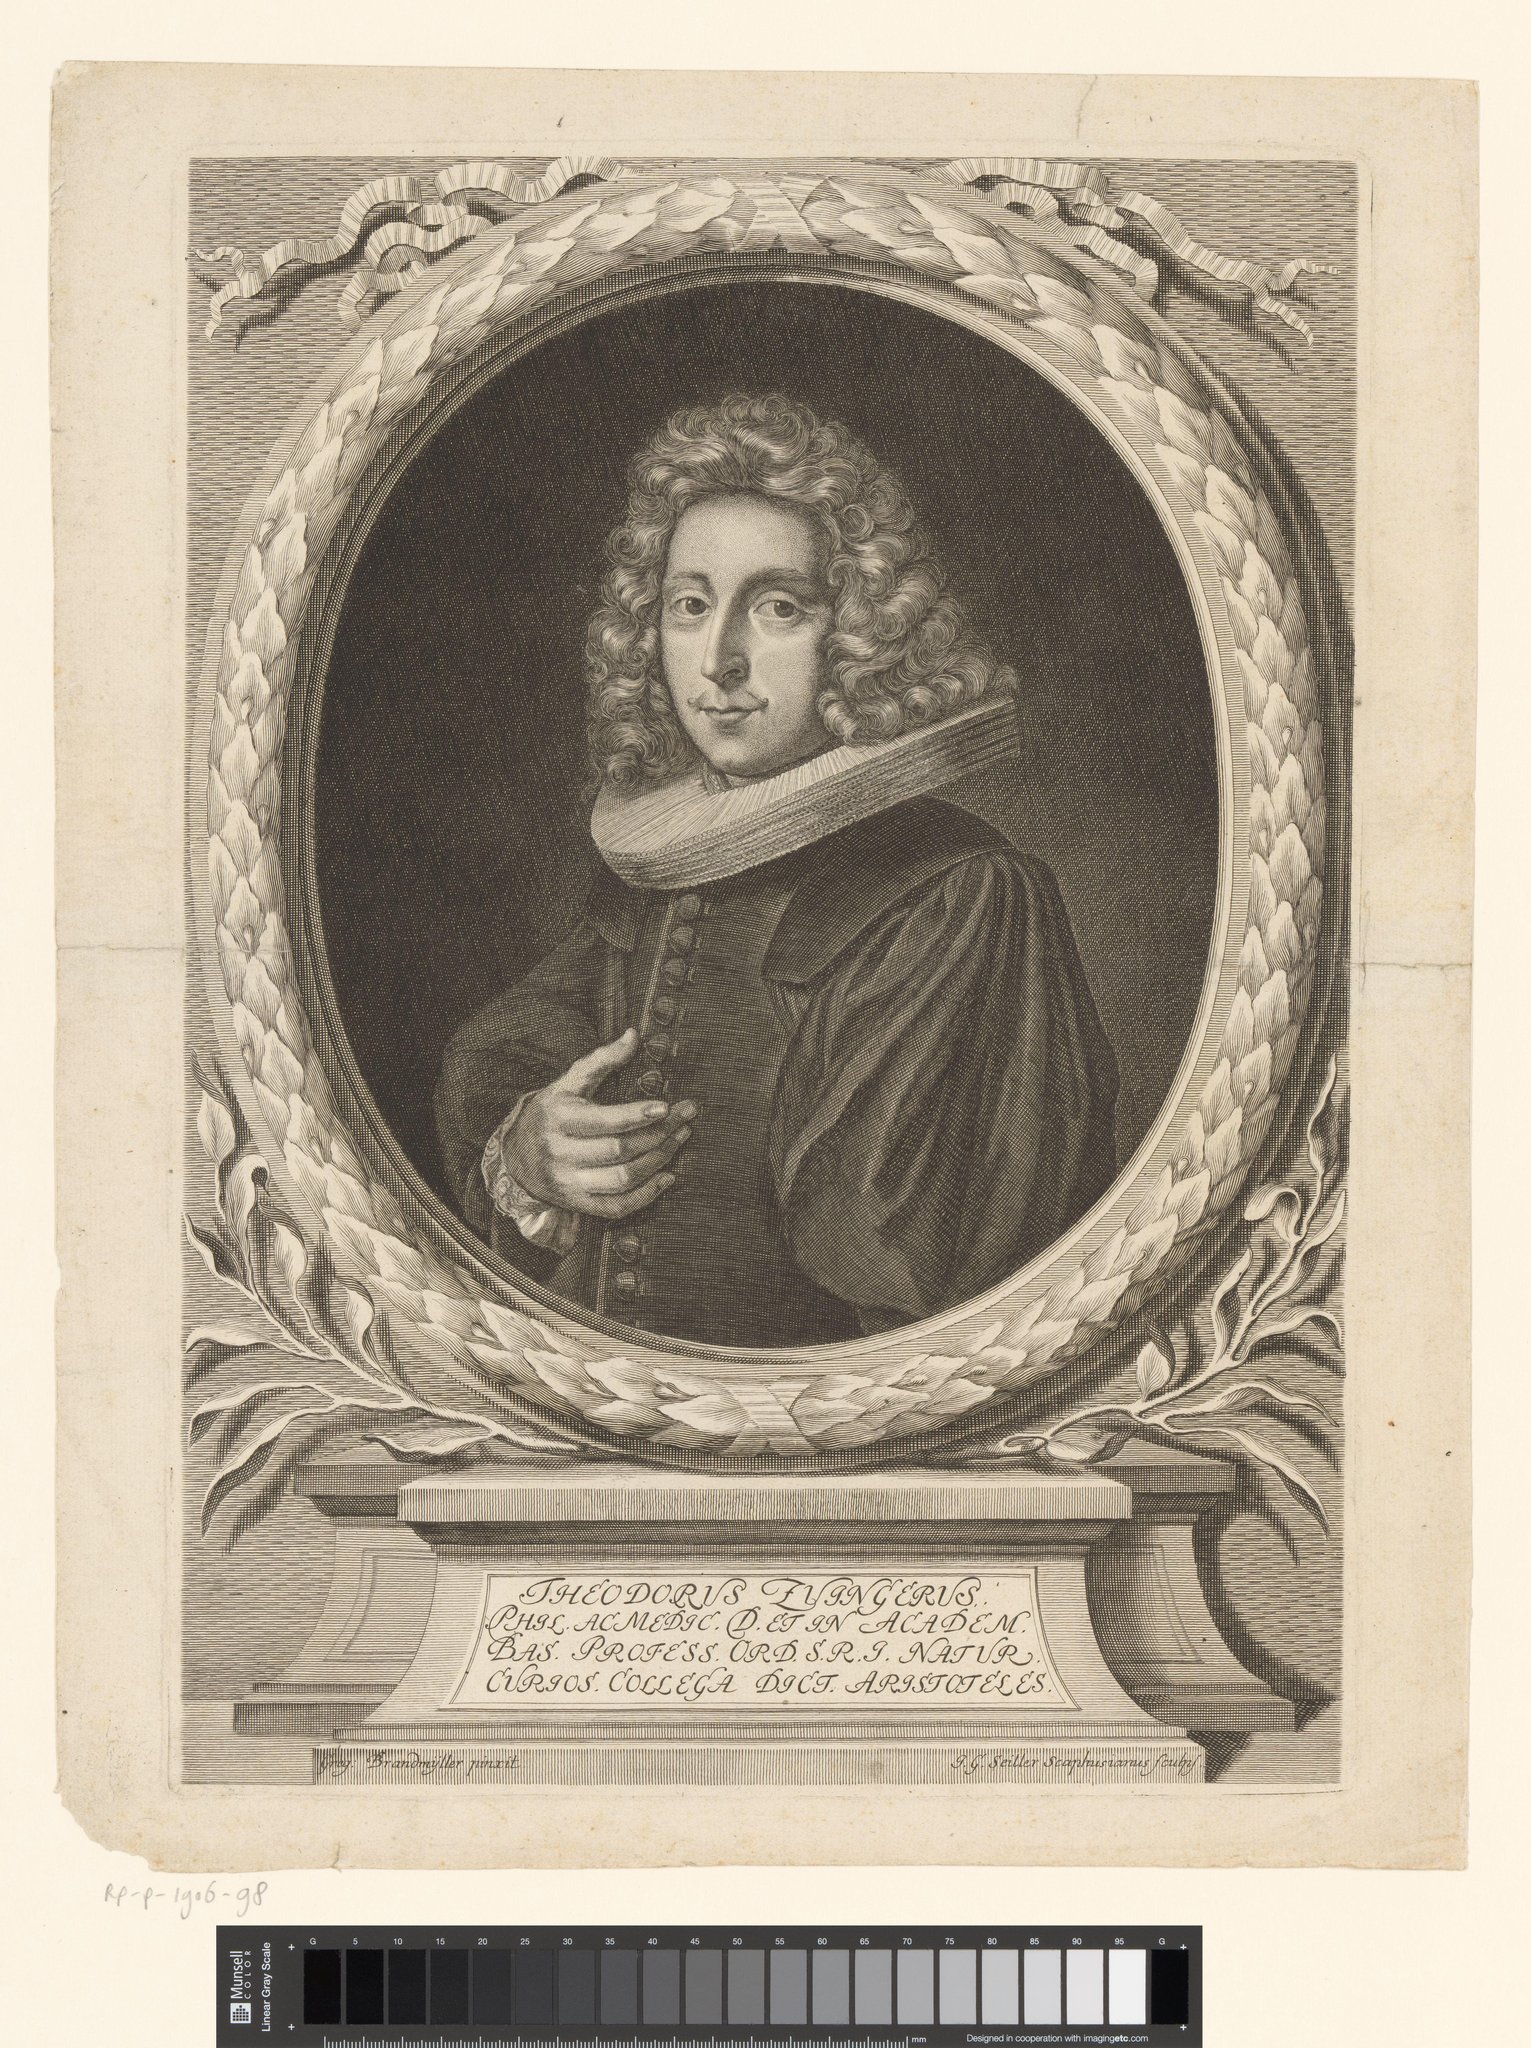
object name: print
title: Portret van Theodor Zwinger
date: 1673-1740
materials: paper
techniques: engraving, etching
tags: historical persons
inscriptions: collector's mark: Lugt 2228